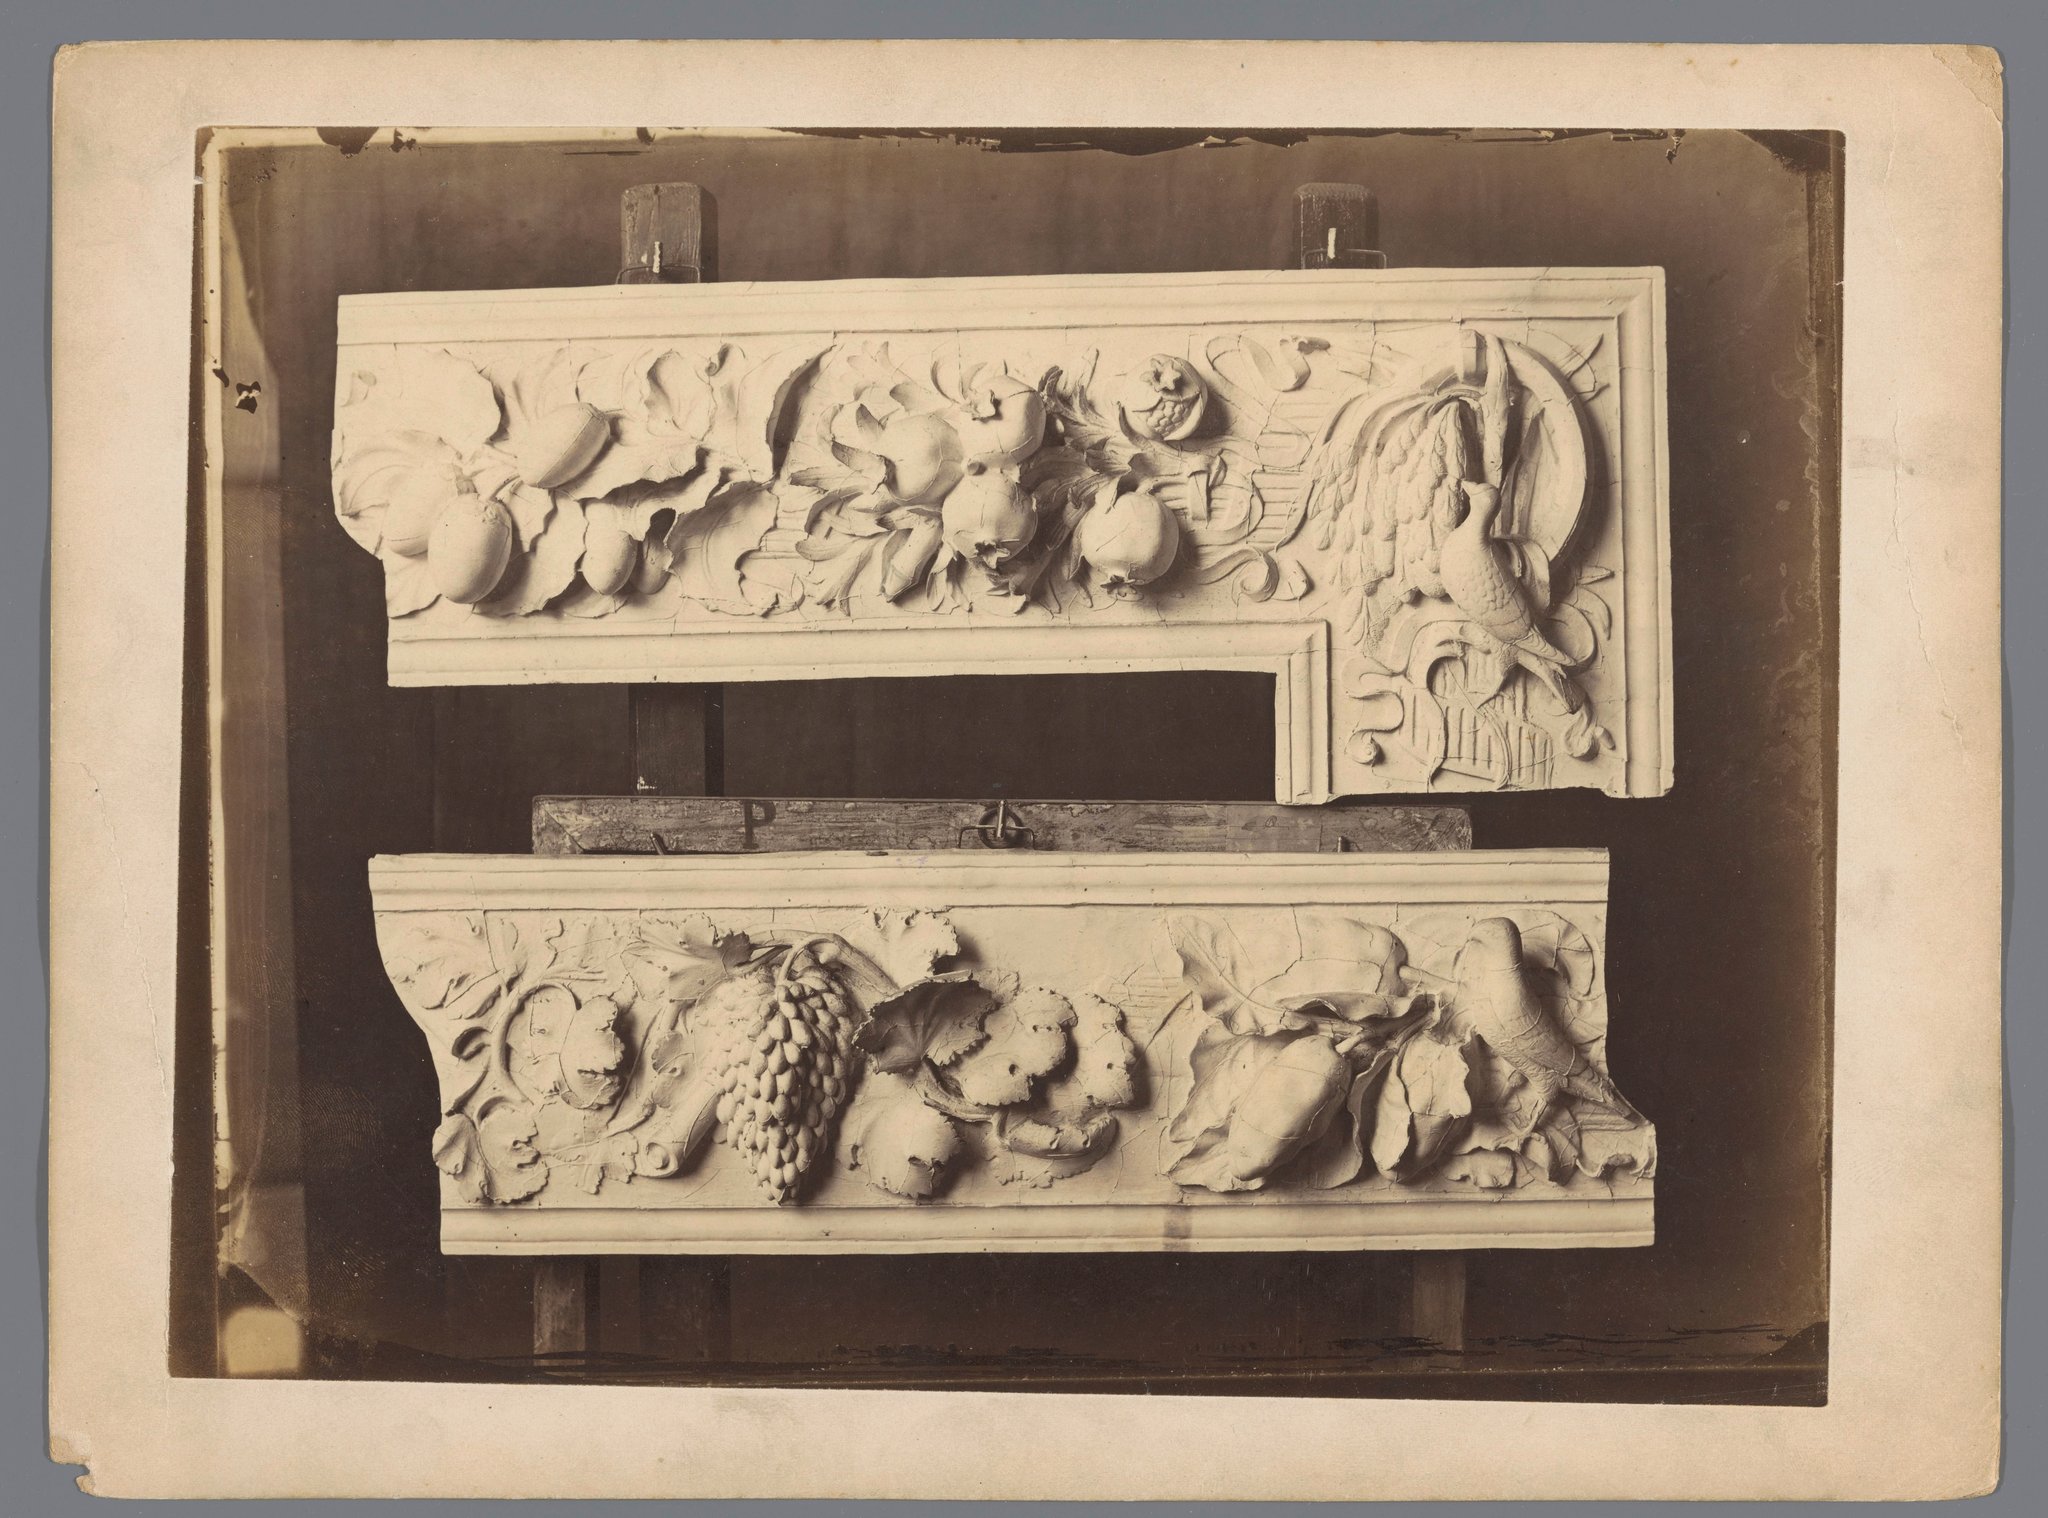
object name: photograph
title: Twee reliëfs met fruit en vogels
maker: gustave eugène chauffourier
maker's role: fotograaf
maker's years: 1845-1919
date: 1875-1900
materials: photographic support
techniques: albumen print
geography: italy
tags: ornamental birds, fruits and vegetables ~ ornament, sculpture (+ relief ~ sculpture)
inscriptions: collector's mark: Lugt 3937